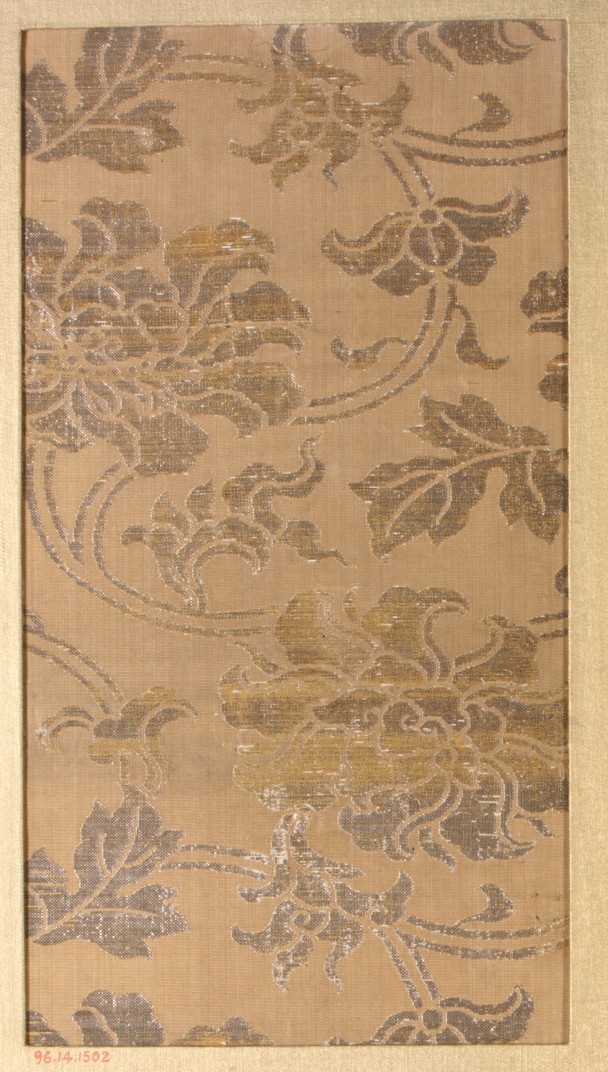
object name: piece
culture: japanese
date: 1701-1900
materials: silk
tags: flowers